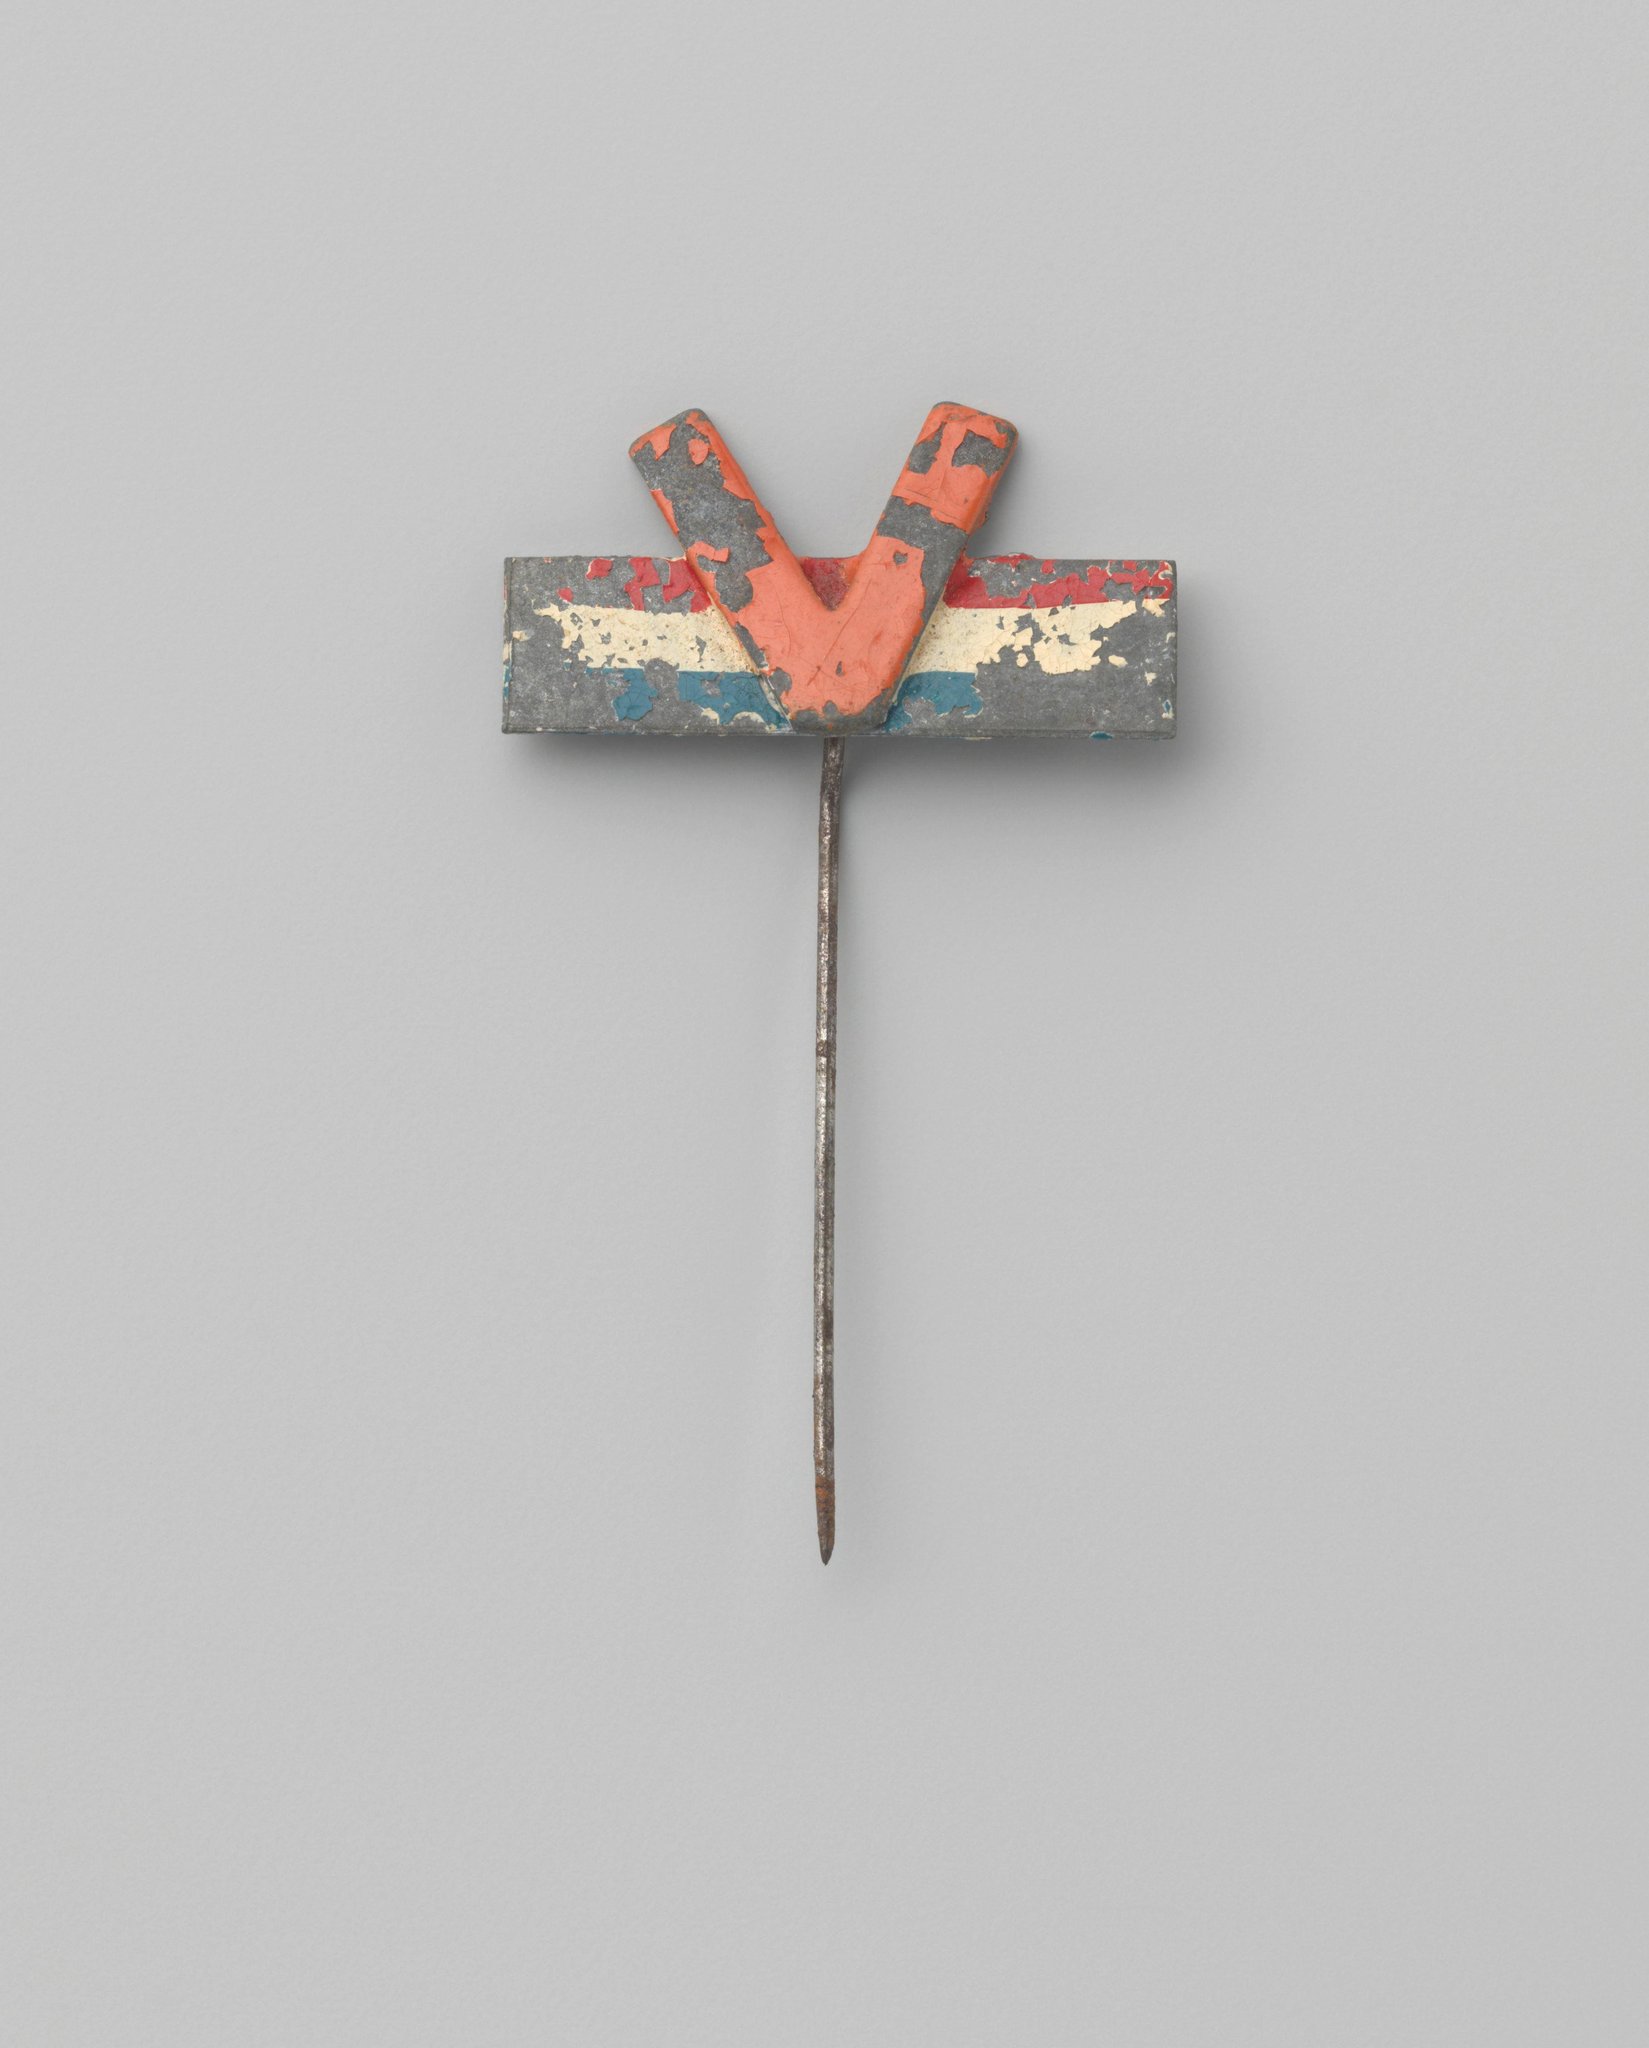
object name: lapel pin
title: Miscellaneous brooches and coin jewels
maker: Anonymous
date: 1940-1945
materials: aluminum, paint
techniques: painted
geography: netherlands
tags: netherlands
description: Silent Resistance –War and Liberation Jewellery During the Second World War, small pieces of jewellery were worn in the Netherlands as a silent protest against the German occupier. In April 1941, Dutch coins were officially confiscated for the war industry. As jewellery did not have to be surrendered, coins were quickly transformed into rings, brooches, pins and bracelets. A portrait of Queen Wilhelmina was worn as a sign of resistance, as well as a token of loyalty to the royal family. Margriet Francisca, the third daughter of Princess Juliana and Prince Bernard, was born in Canada in January 1943. The pin with the three yellow chicks refers to the three young princesses Beatrix, Irene and Margriet and the steadfastness of the Dutch royal family. After the liberation, coins and silver were used for jewellery conveying messages of hope for a peaceful future.